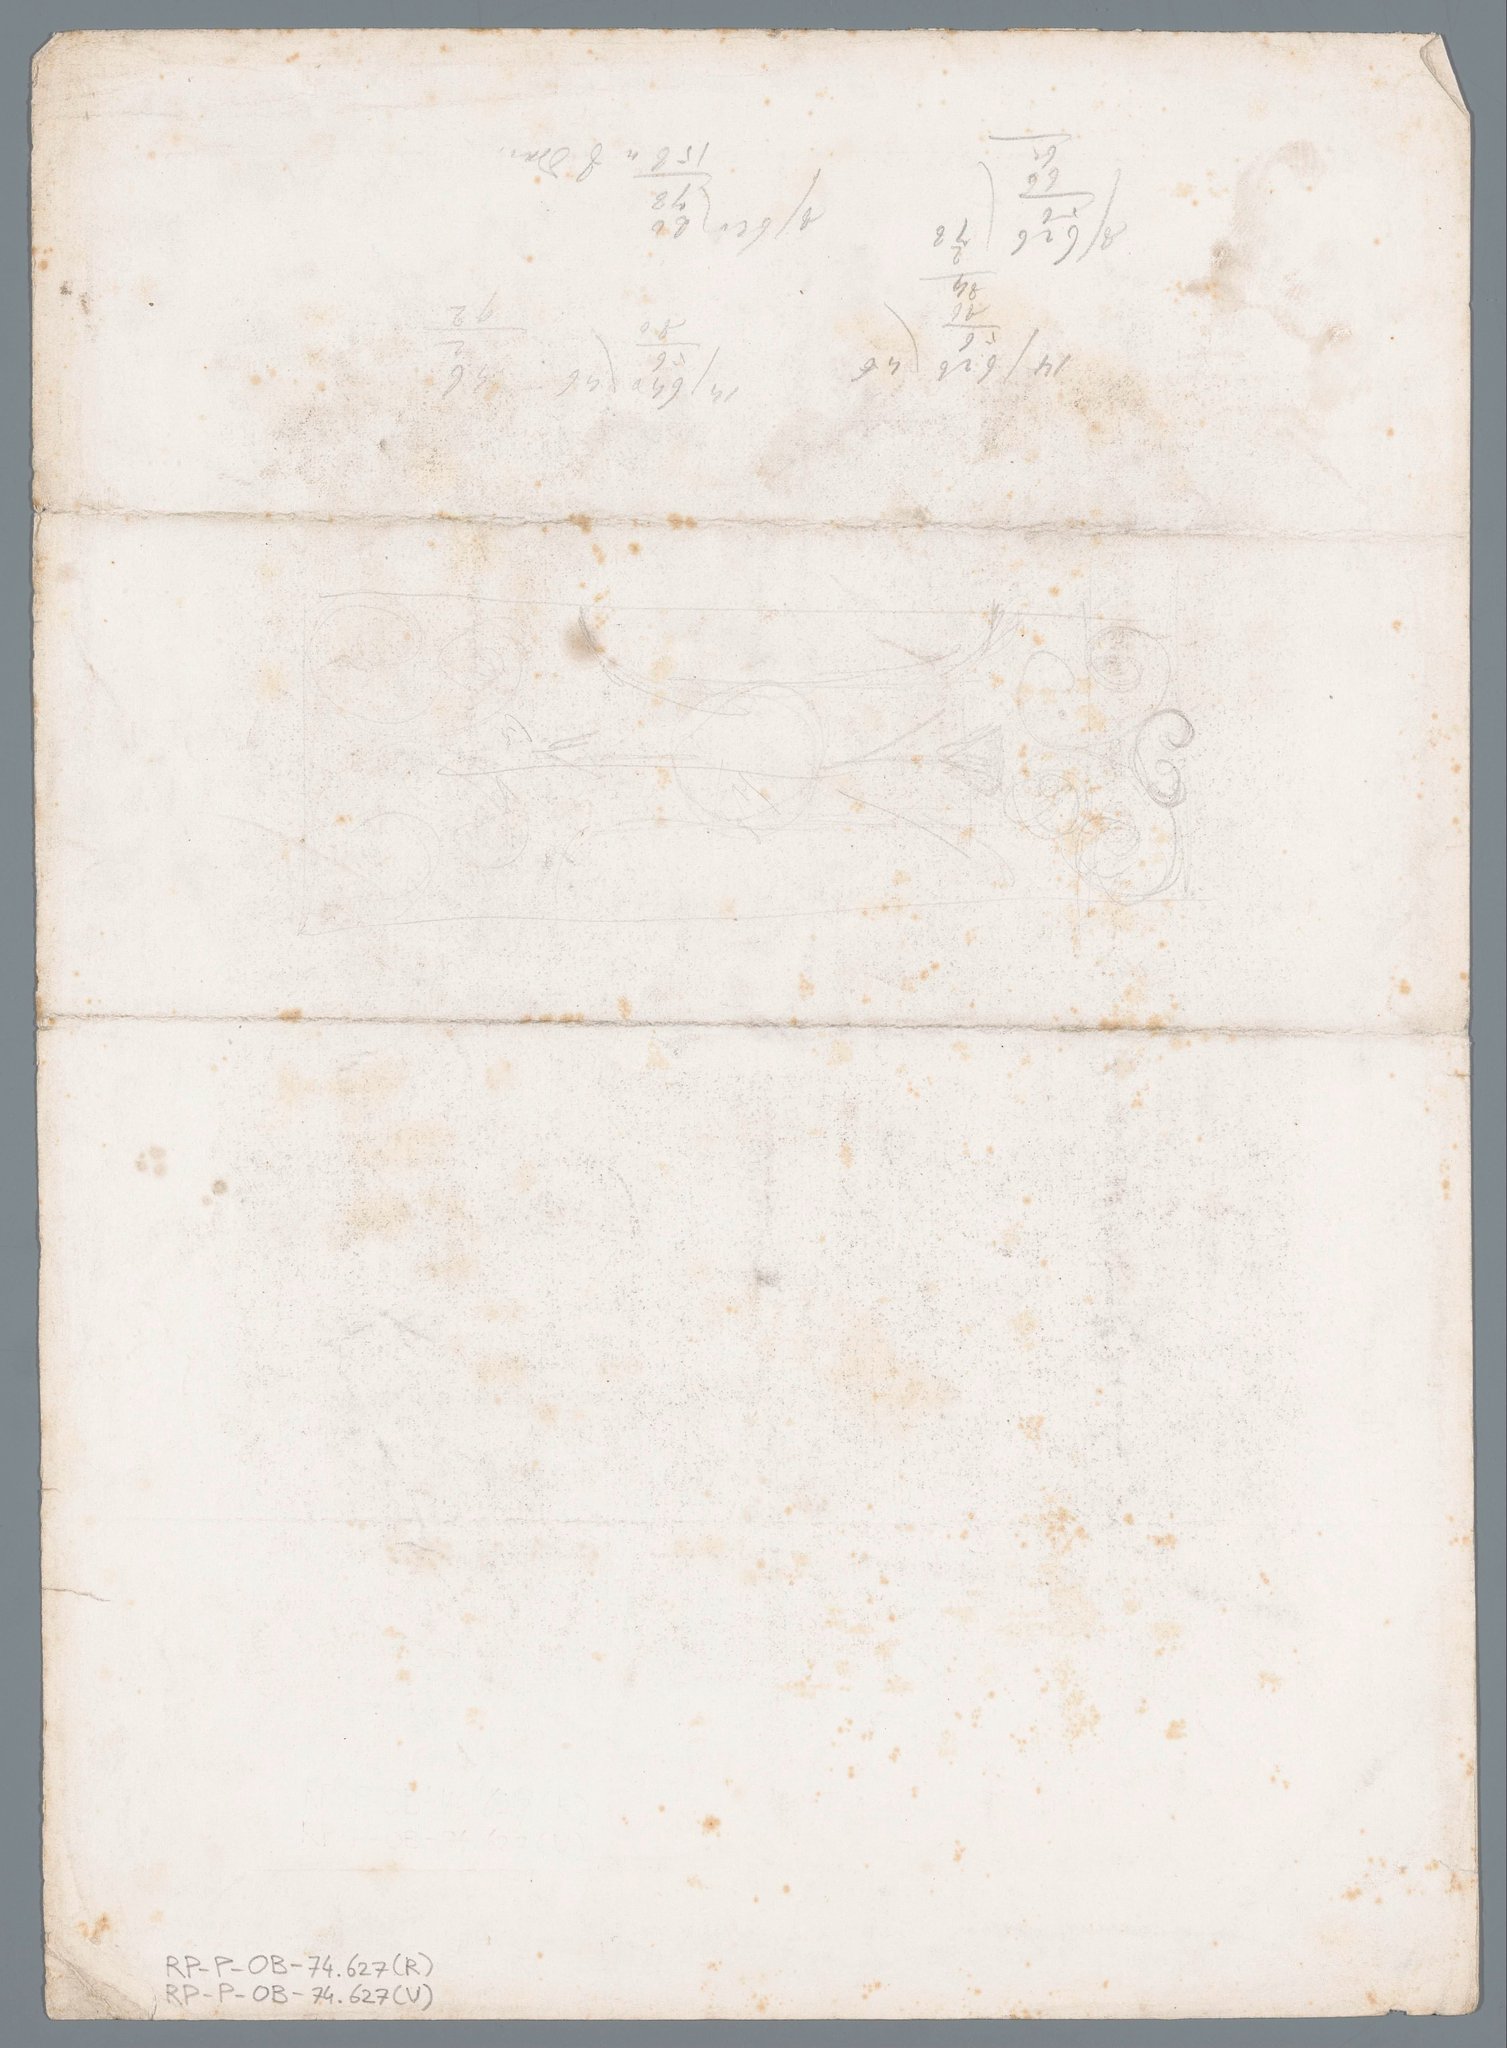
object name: drawing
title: Architecturaal sierelement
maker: Anonymous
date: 1860-1899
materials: paper, pencil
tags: architectural detail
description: Verso van een prent afkomstig uit een serie van 48 prenten, uitgegeven tussen 1660-1661 in twaalf delen, getiteld: L'architecture pittoresque en Suisse ou choix de constructions rustiques prises dans toutes les parties de la Suisse. De serie bestaat uit aanzichten en details van traditionele Zwitserse huizen.